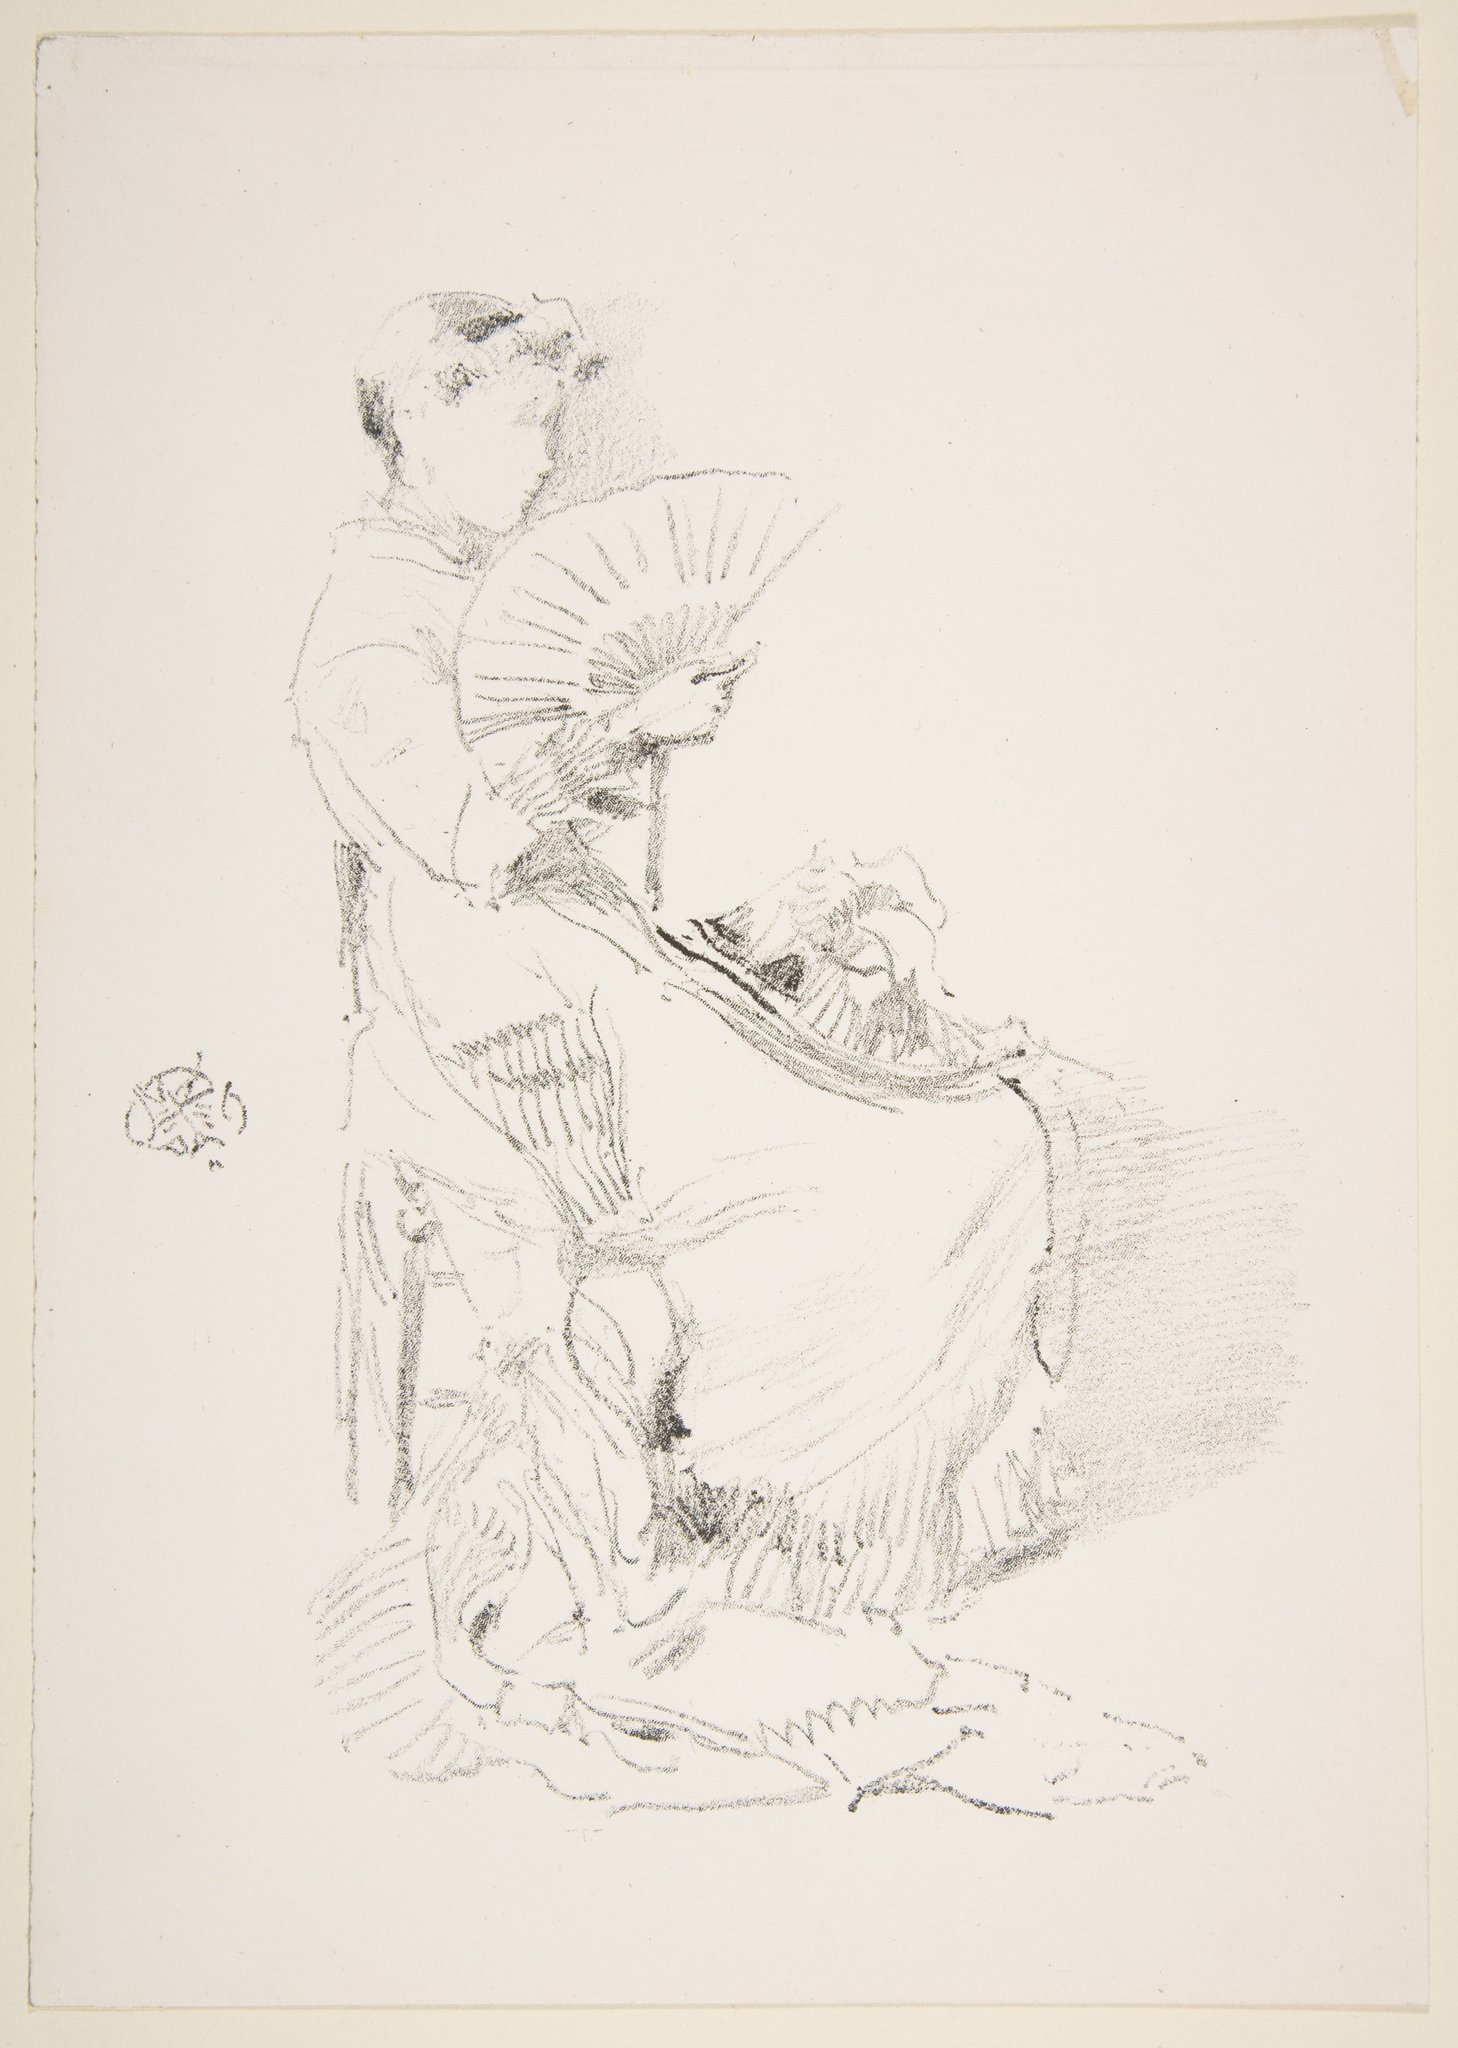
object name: print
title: The Fan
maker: james mcneill whistler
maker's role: artist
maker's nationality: american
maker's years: 1834-1903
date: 1879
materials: ink, paper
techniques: printing, lithography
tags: fans,women